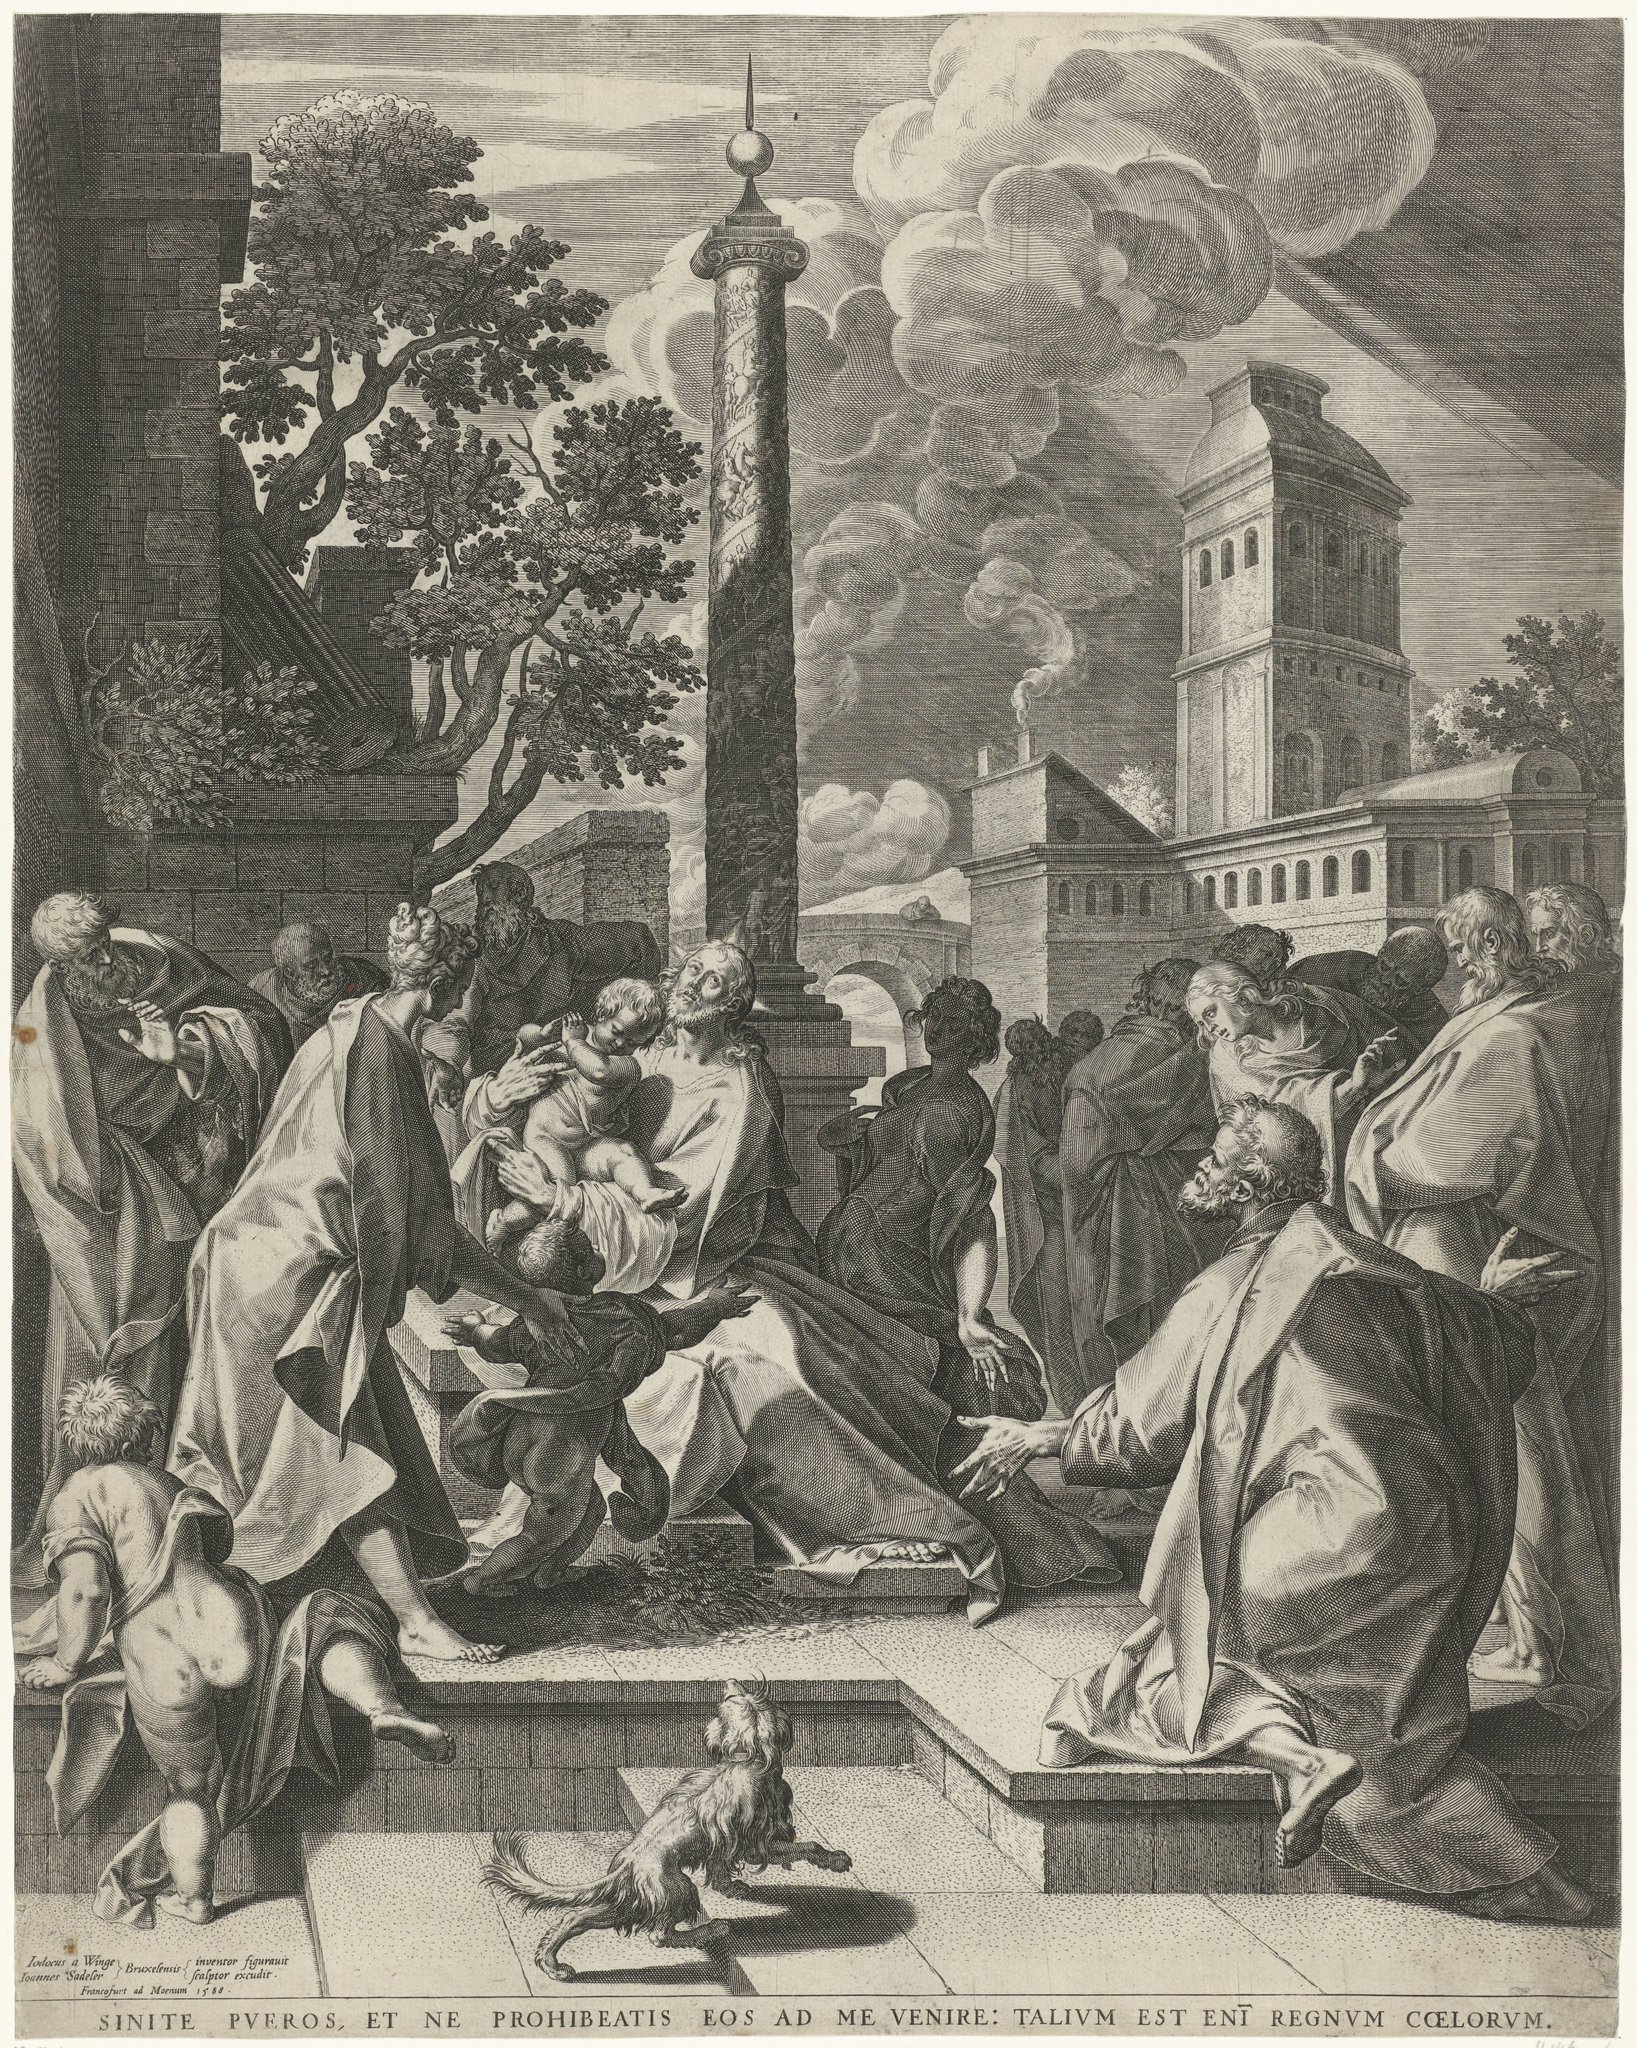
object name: print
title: Christus zegent de kinderen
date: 1588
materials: paper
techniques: engraving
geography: frankfurt am main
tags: obelisk, needle, christ blessing children brought by their mothers, usually with some disciples disapprovingly looking on (matthew 19:13-15; mark 10:13-16; luke 18:15-17)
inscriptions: number: ‘15 44’, collector's mark: Lugt 240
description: Voor een obelisk zit Christus met een kind op schoot. Om hem heen moeders met kinderen en de apostelen.